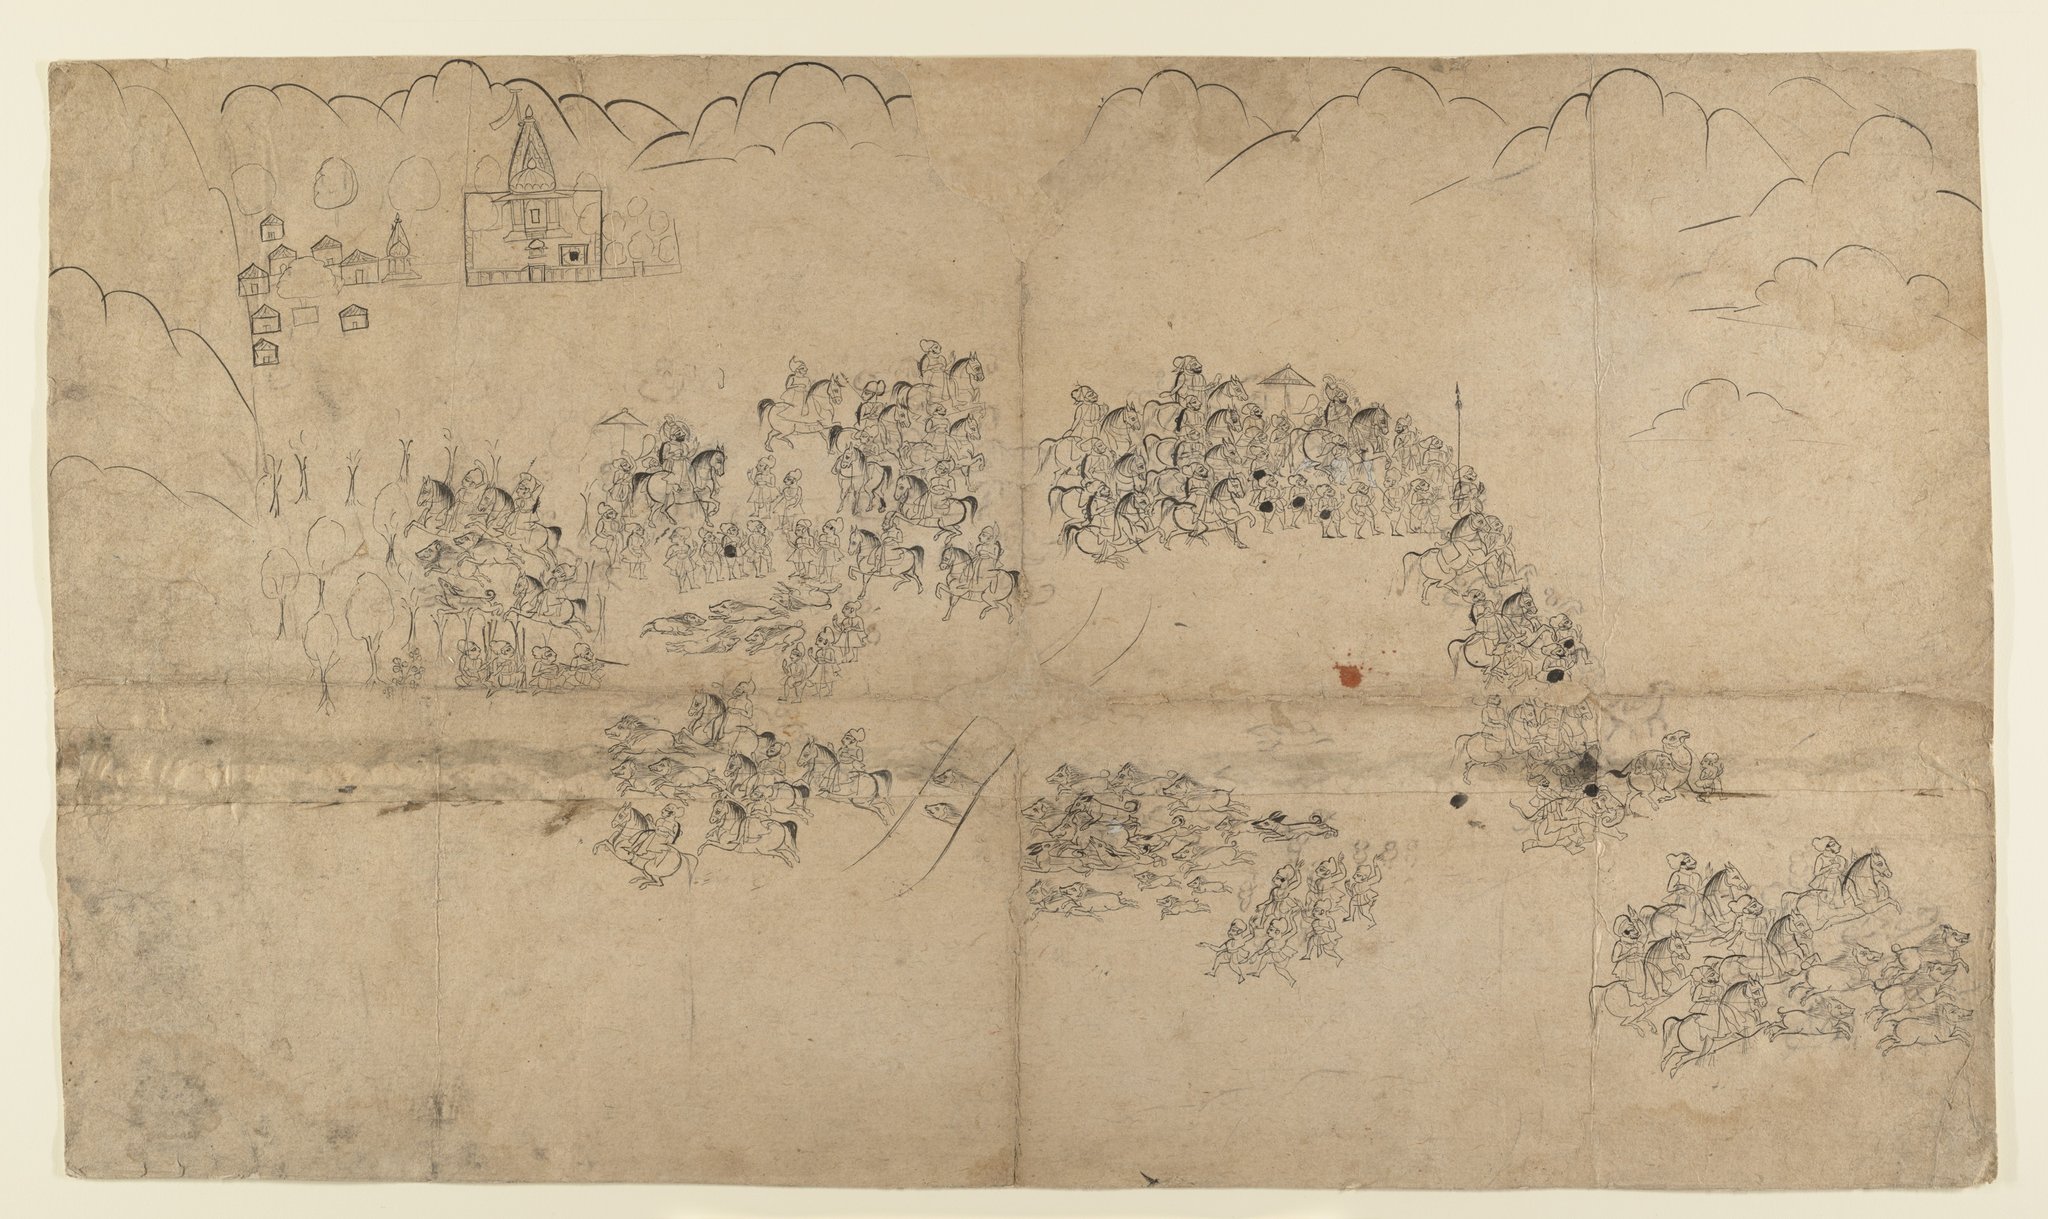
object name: painting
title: A Maharana and His Retinue Hunting Boar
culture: western indian, rajasthan, udaipur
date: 1701-1733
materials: ink, paper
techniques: wash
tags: men,hunting,boars,horses